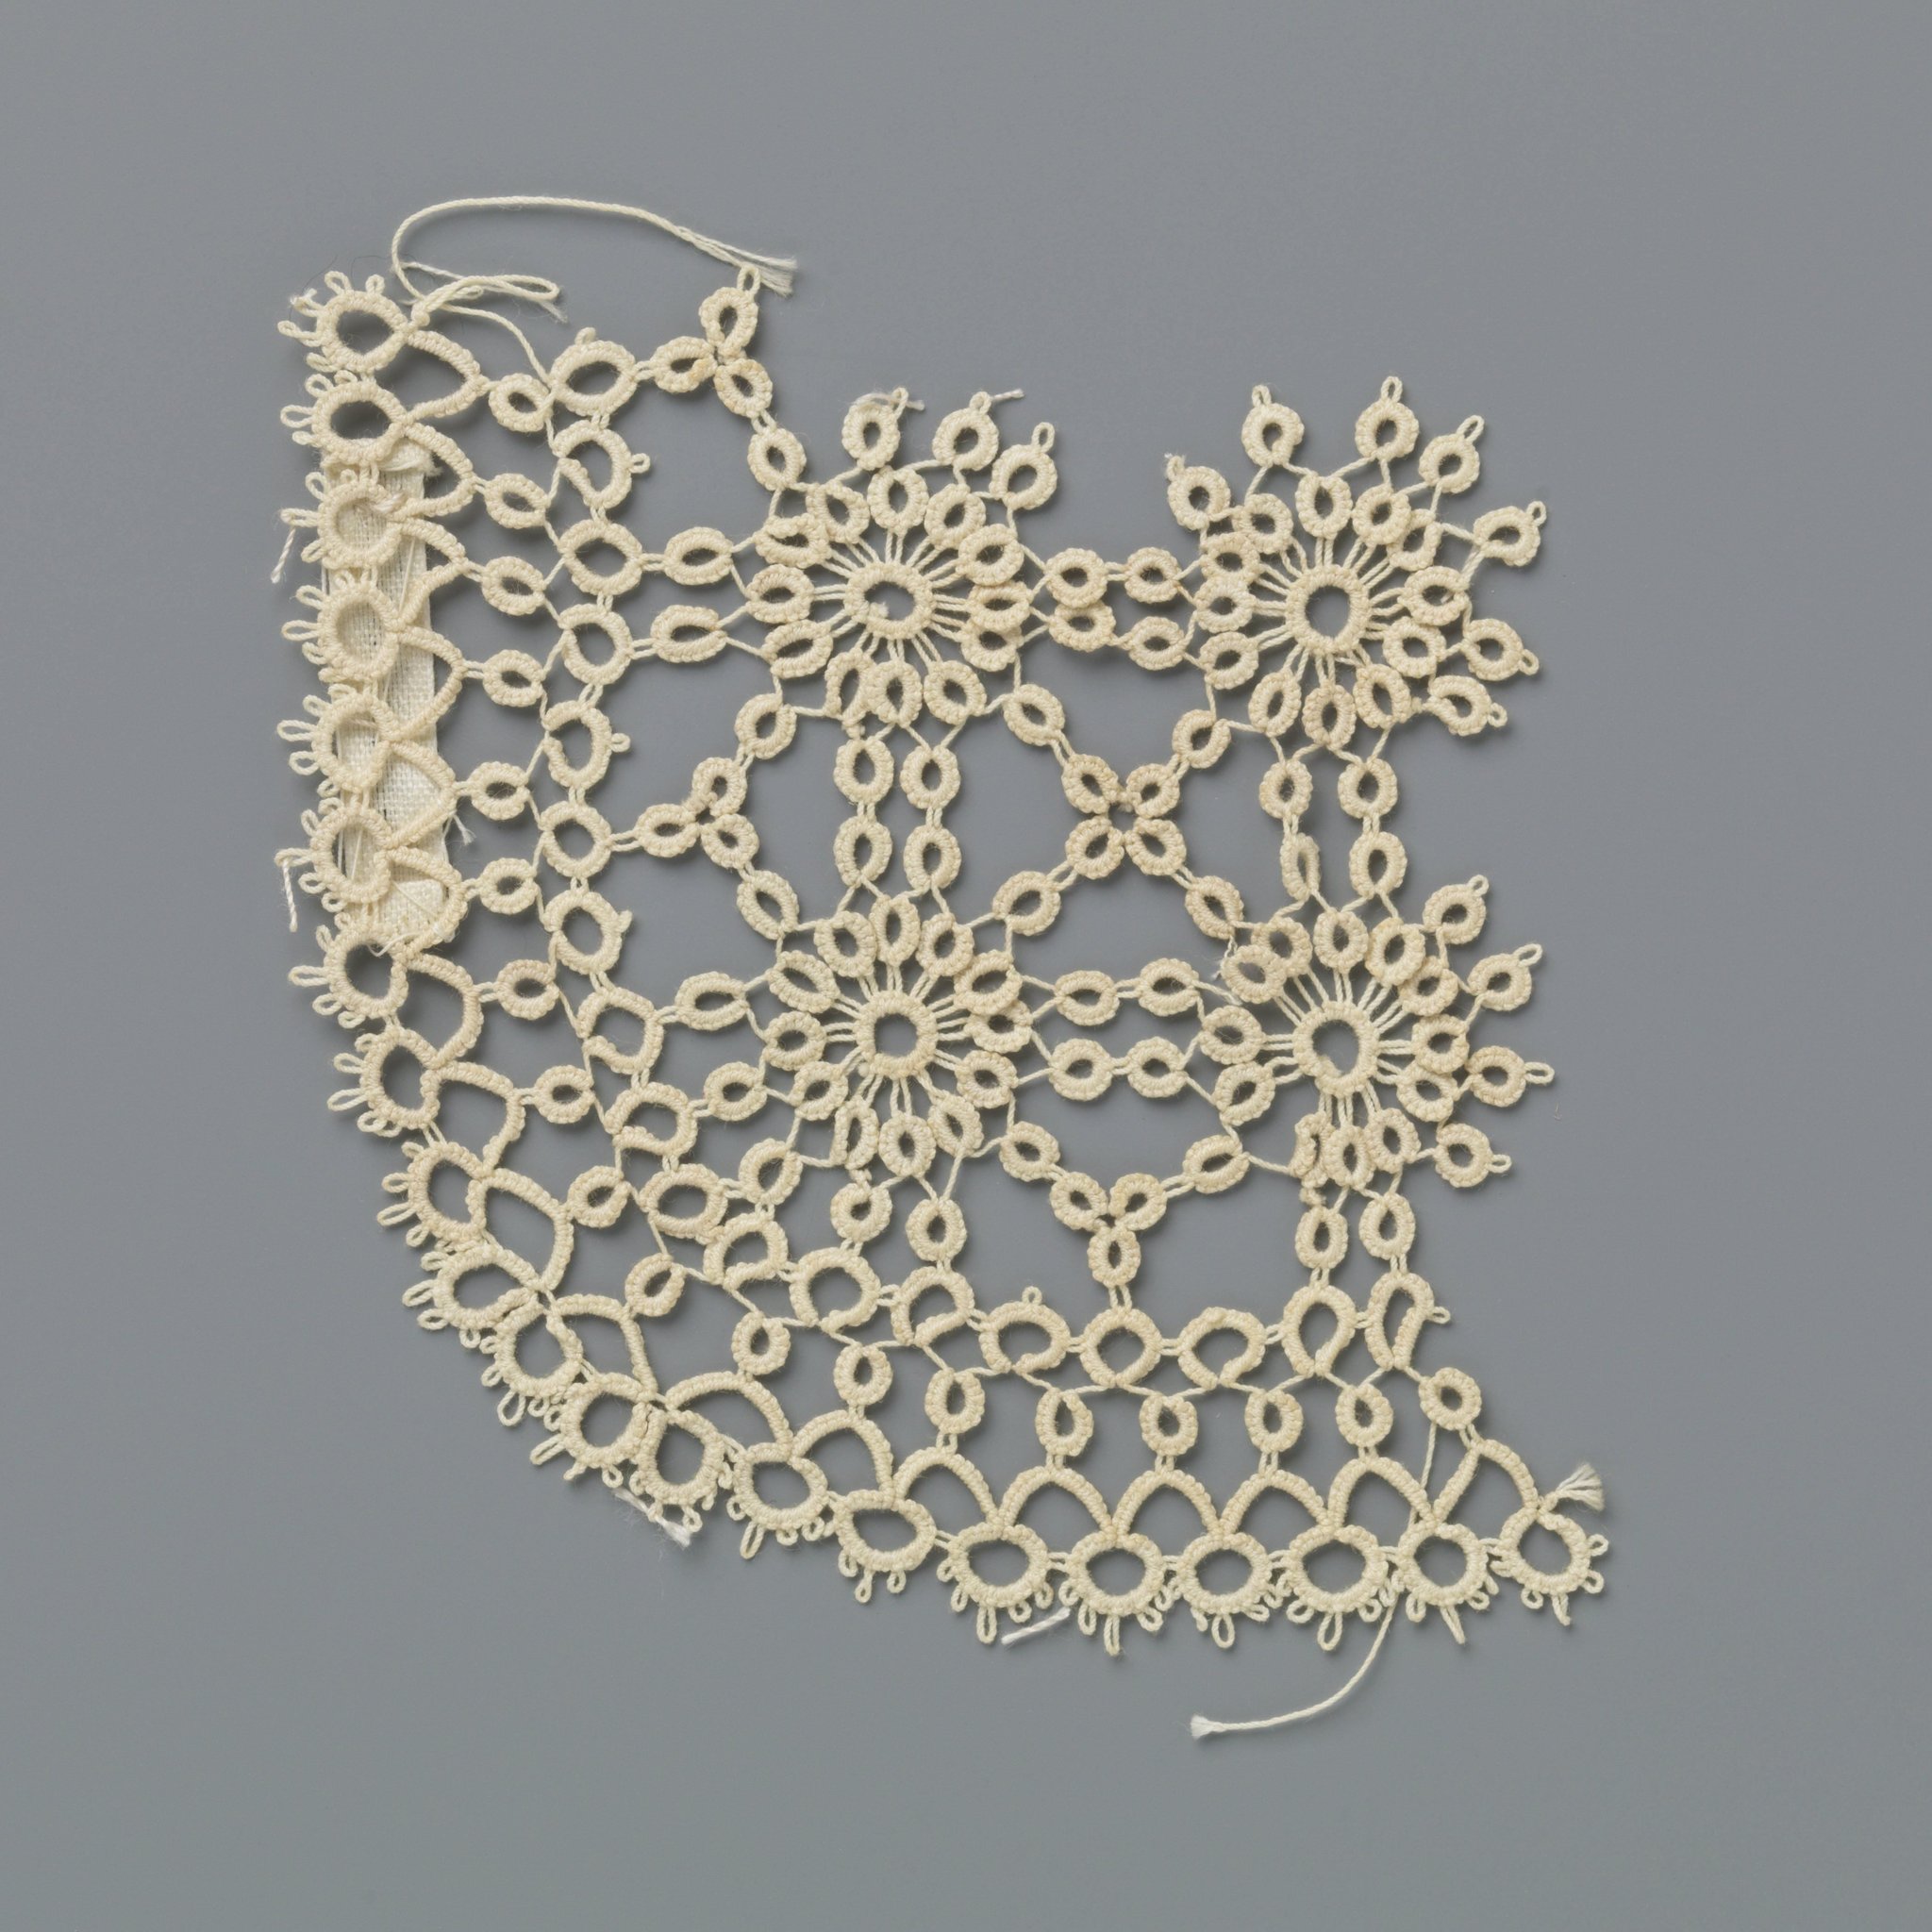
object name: fragment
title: Fragment spoeltjeswerk met vier cirkeltjes en een deel van een sierrand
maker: Anonymous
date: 1850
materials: linen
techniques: tatting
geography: europe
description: Fragment naturelkleurige geknoopte kant: frivolité. Patroon met vier cirkeltjes en een deel van een sierrand. De cirkeltjes staan in een vierkante compositie. Een sierband loopt langs twee zijden en vormt een afgeronde hoek. Onafgewerkte uiteinden.